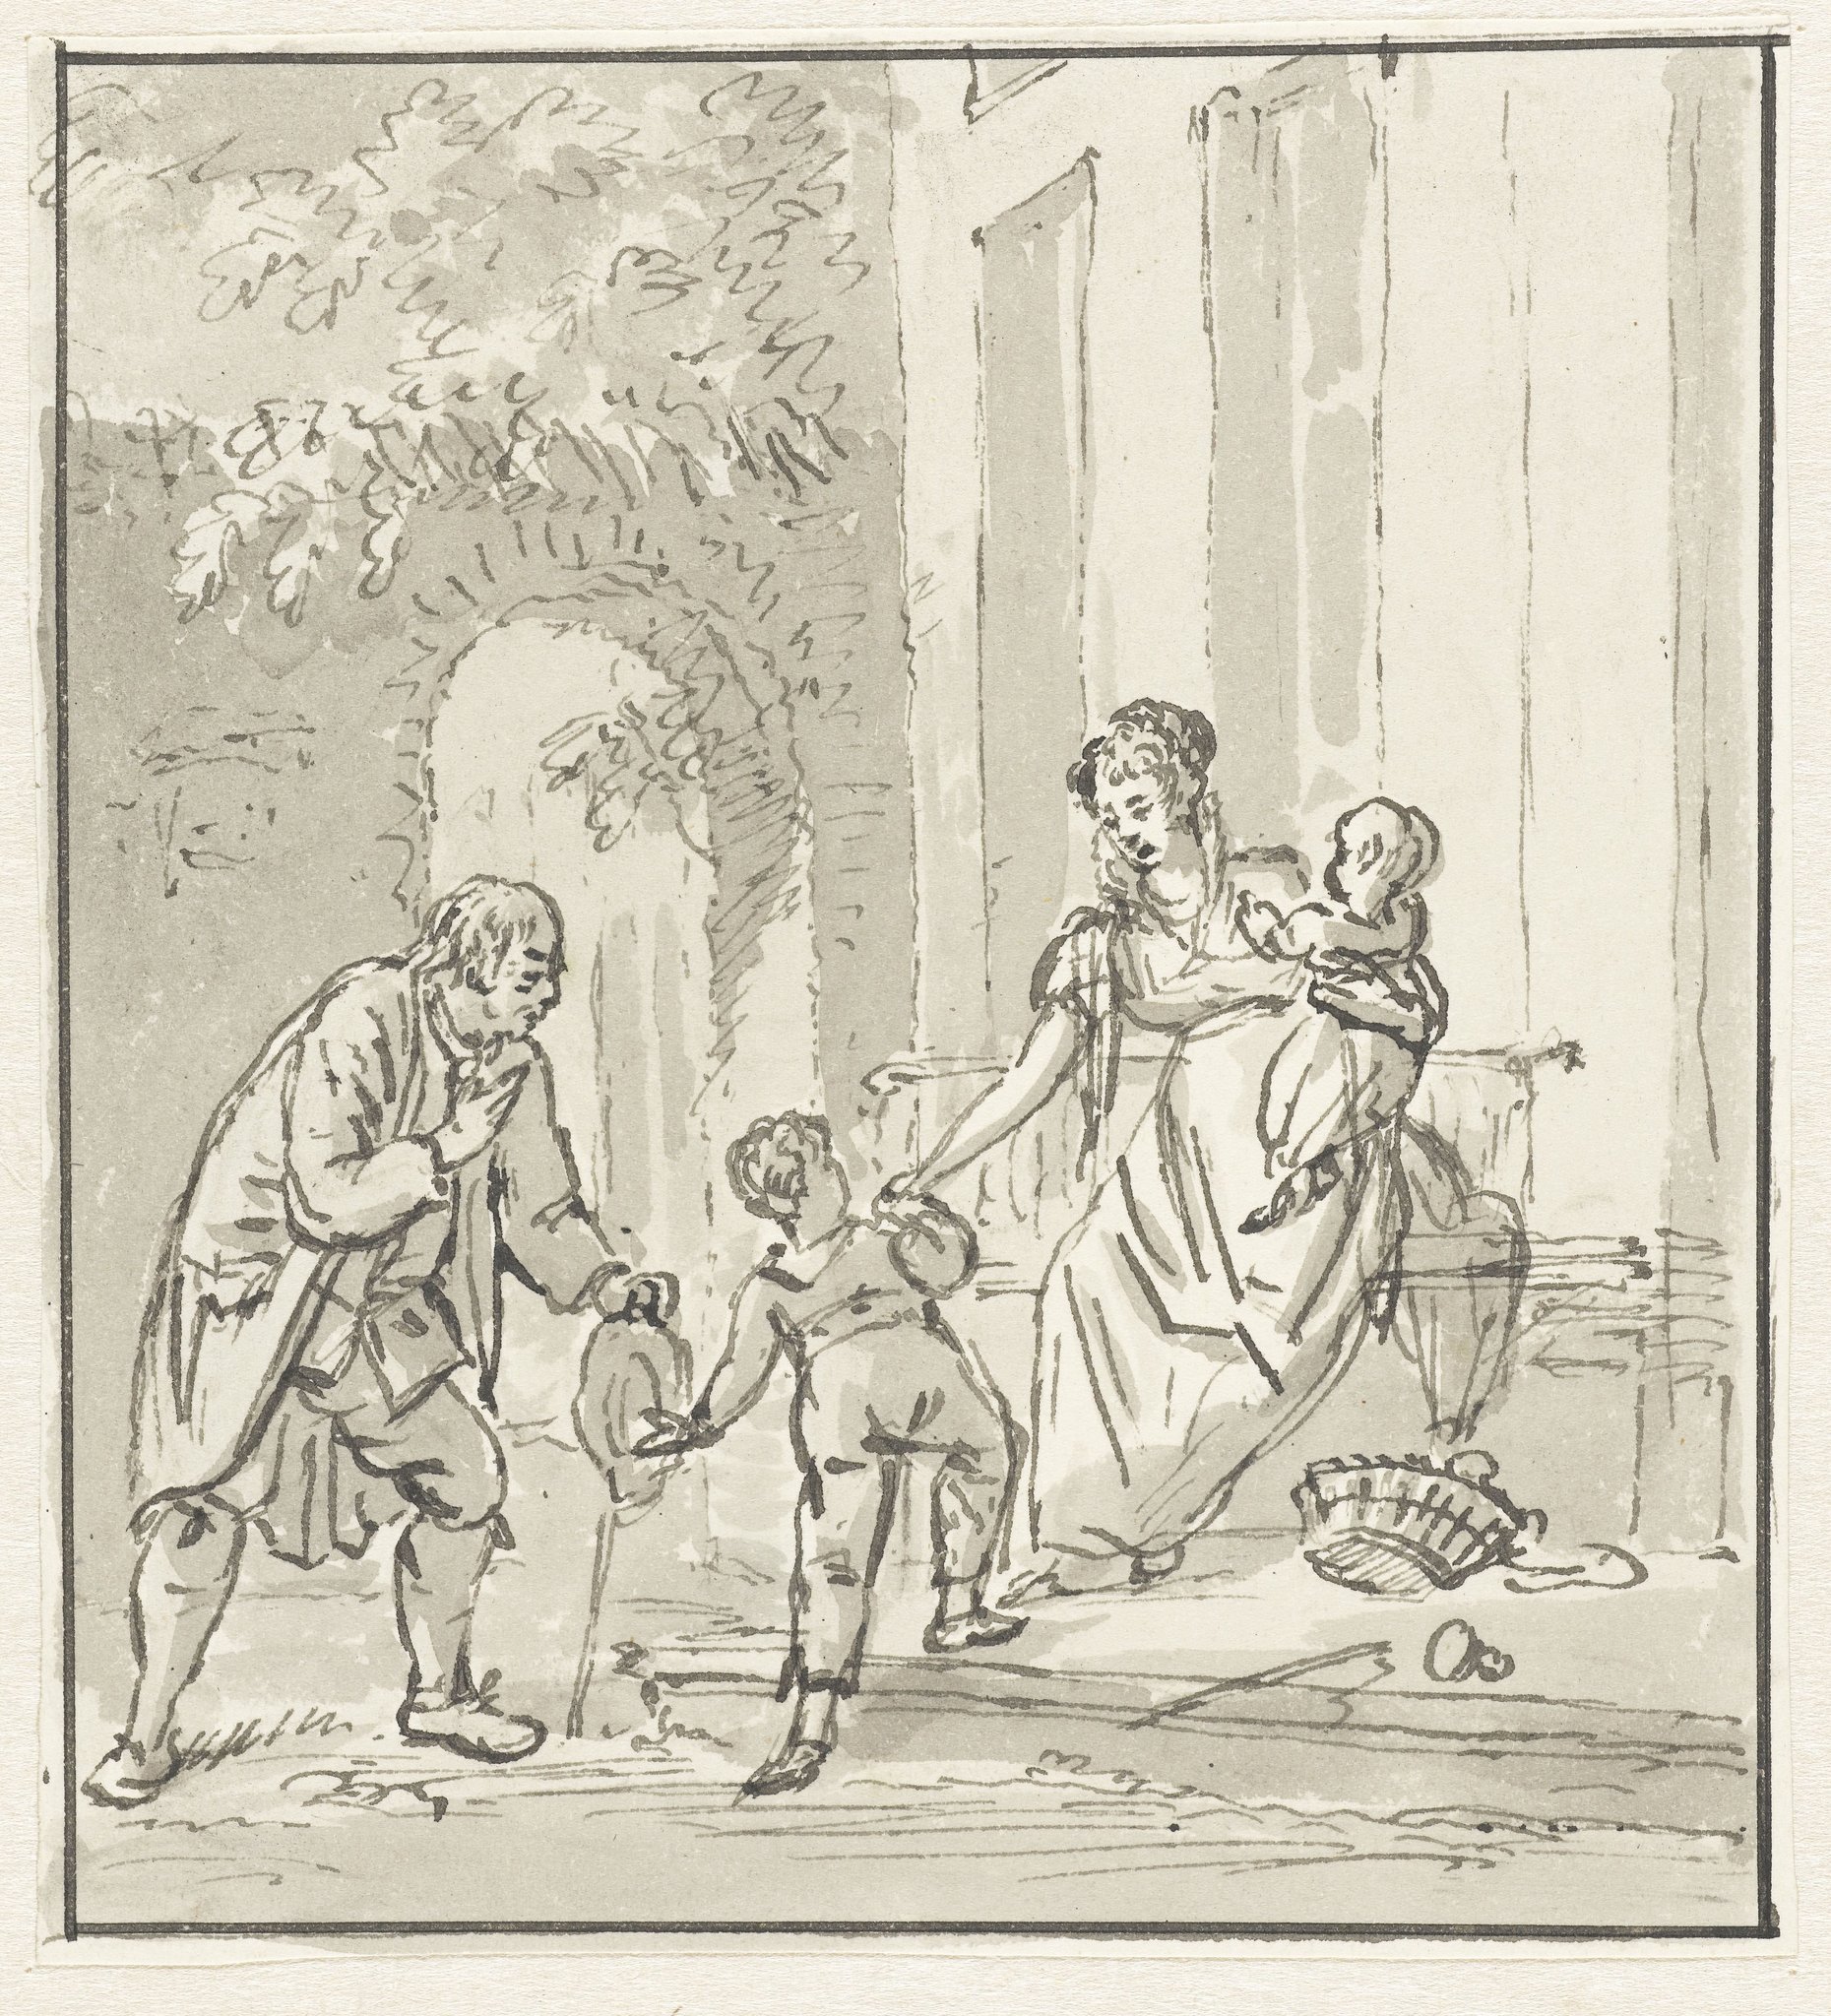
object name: drawing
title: Familie voor een huis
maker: pieter bartholomeusz. barbiers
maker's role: draughtsman, print maker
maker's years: 1772-1837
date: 1782-1873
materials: graphite, ink, paper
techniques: brush